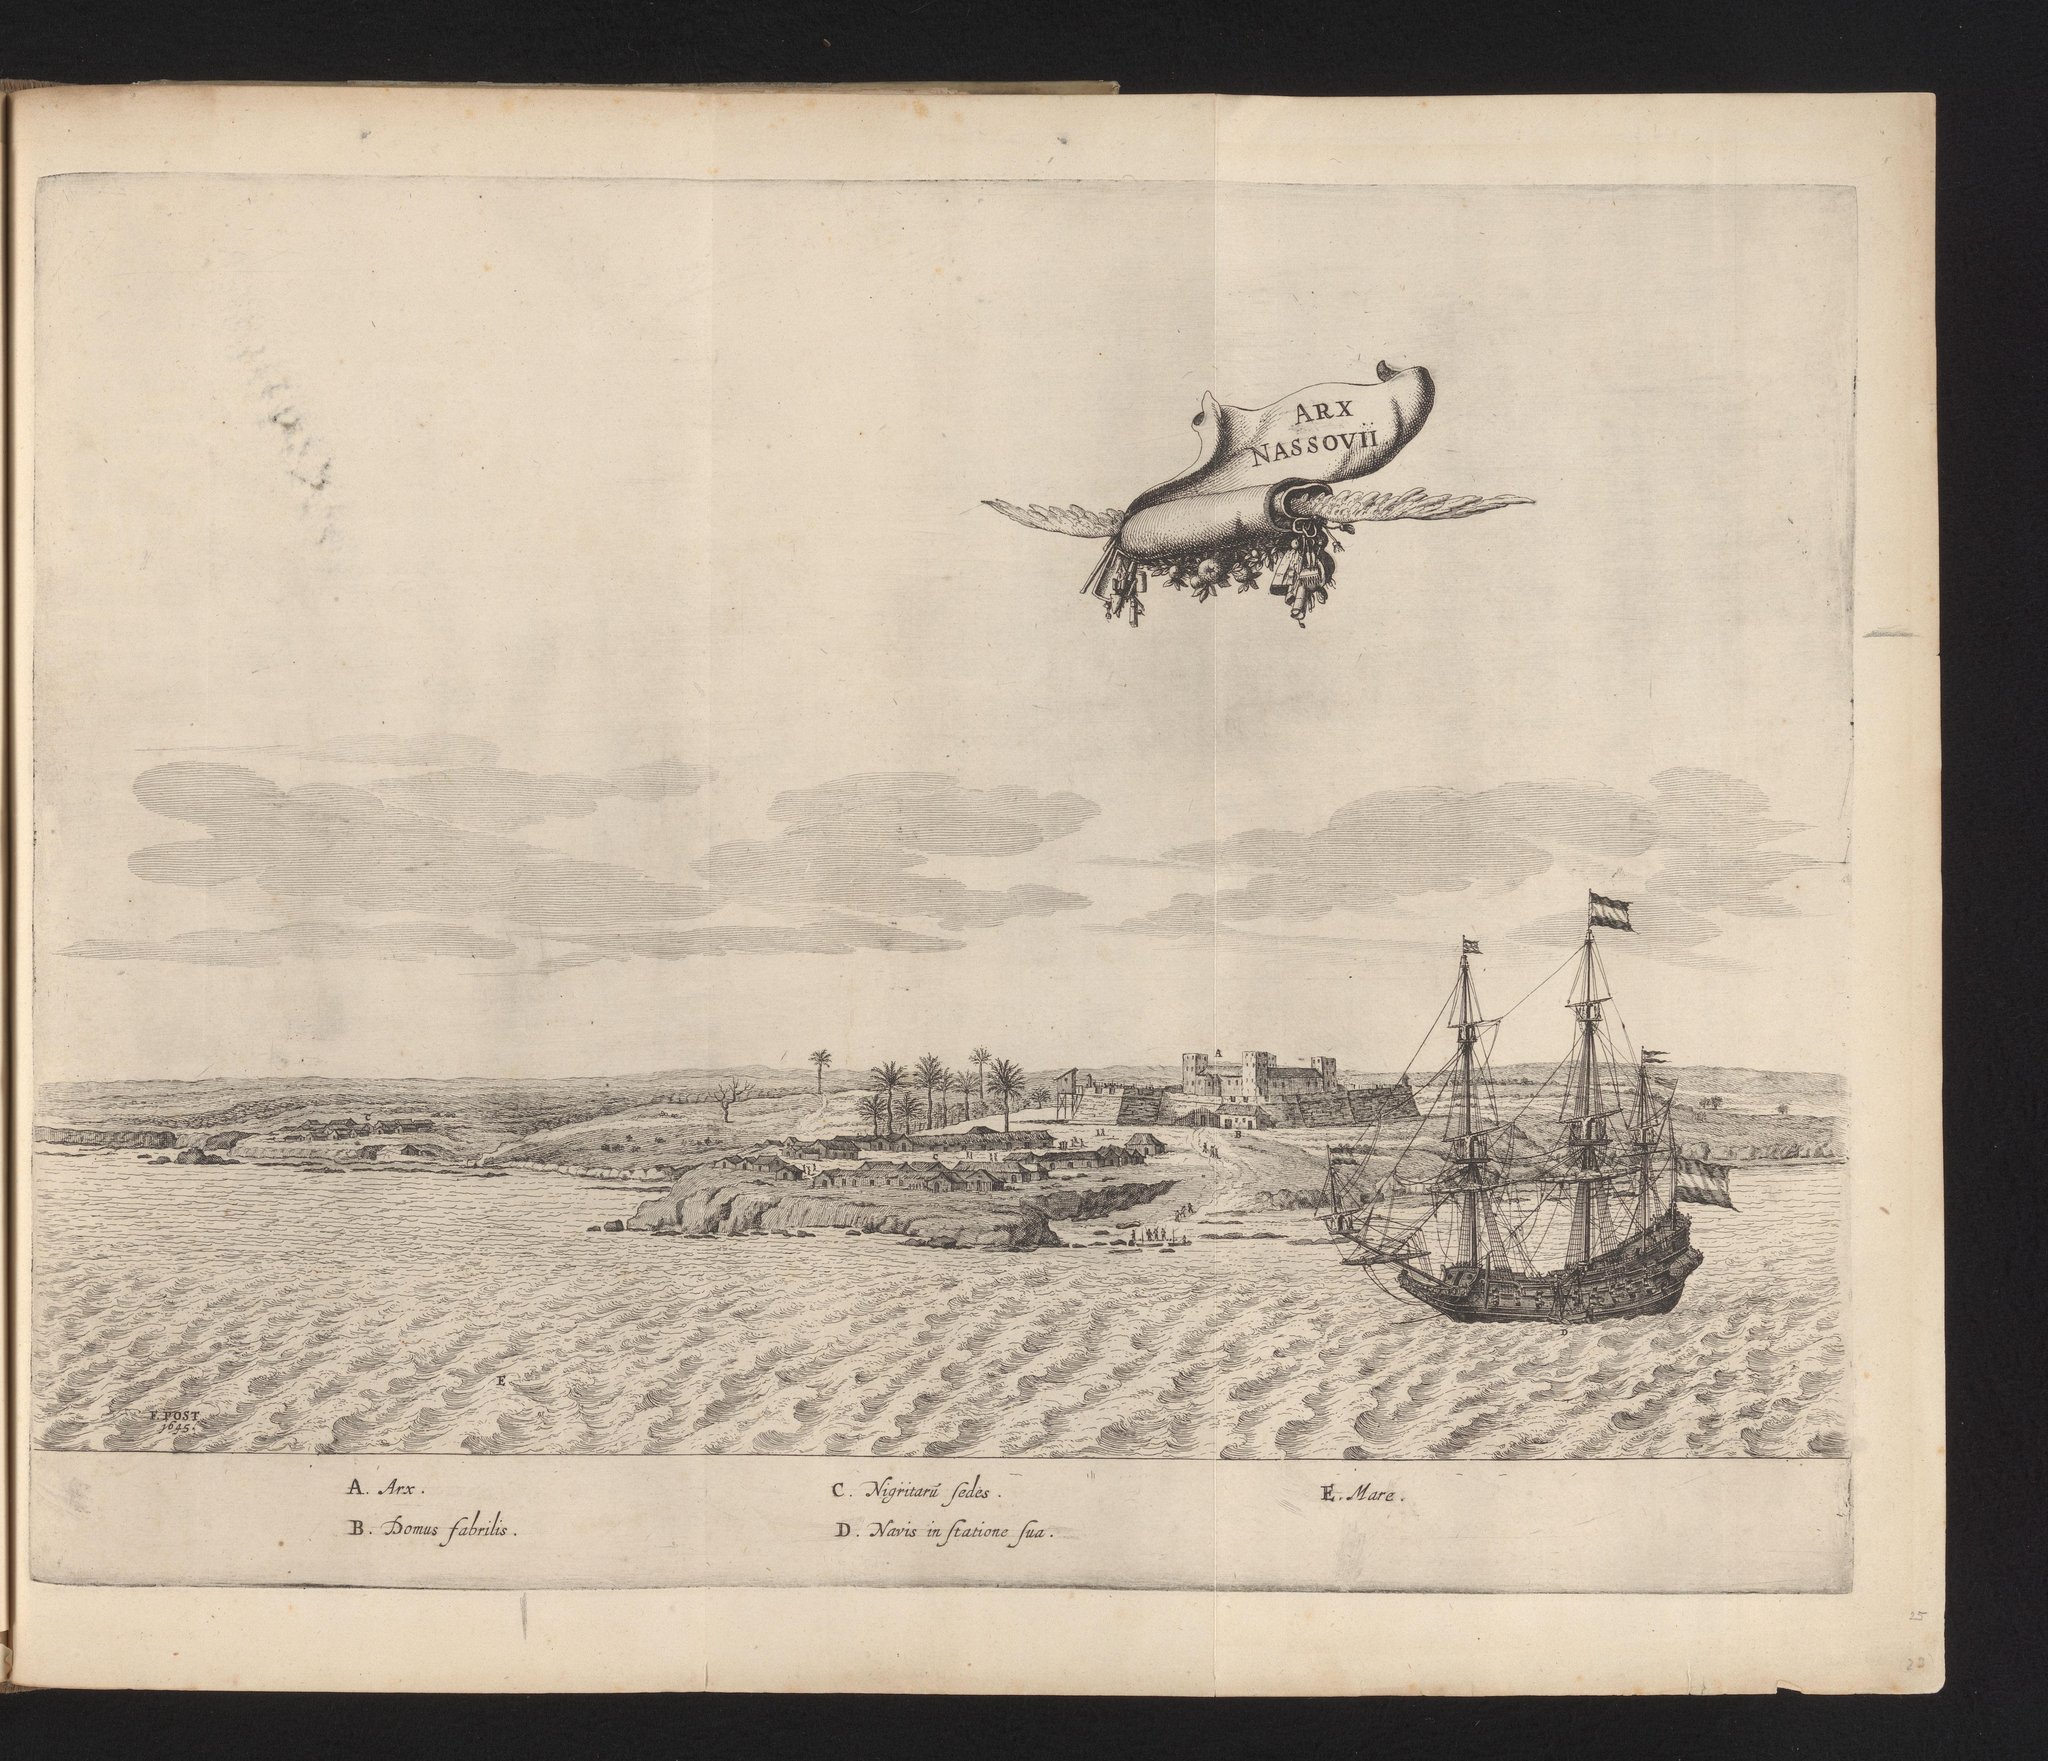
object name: print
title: Gezicht op fort Nassau, ca. 1636-1644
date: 1645-1647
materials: paper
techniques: engraving, etching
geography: northern netherlands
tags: earl, johan maurits graaf van nassau-siegen, fortress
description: Gezicht op fort Nassau, ca. 1636-1644. In de lucht een gevleugelde banderol met de titel. In het onderschrift de verklaring van de letters A-E in het Latijn. Plaat [nr. 23] in een serie van 55 voorstellingen van de tocht naar en het verblijf in Brazilië van graaf Johan Maurits van Nassau in de jaren 1636-1644.